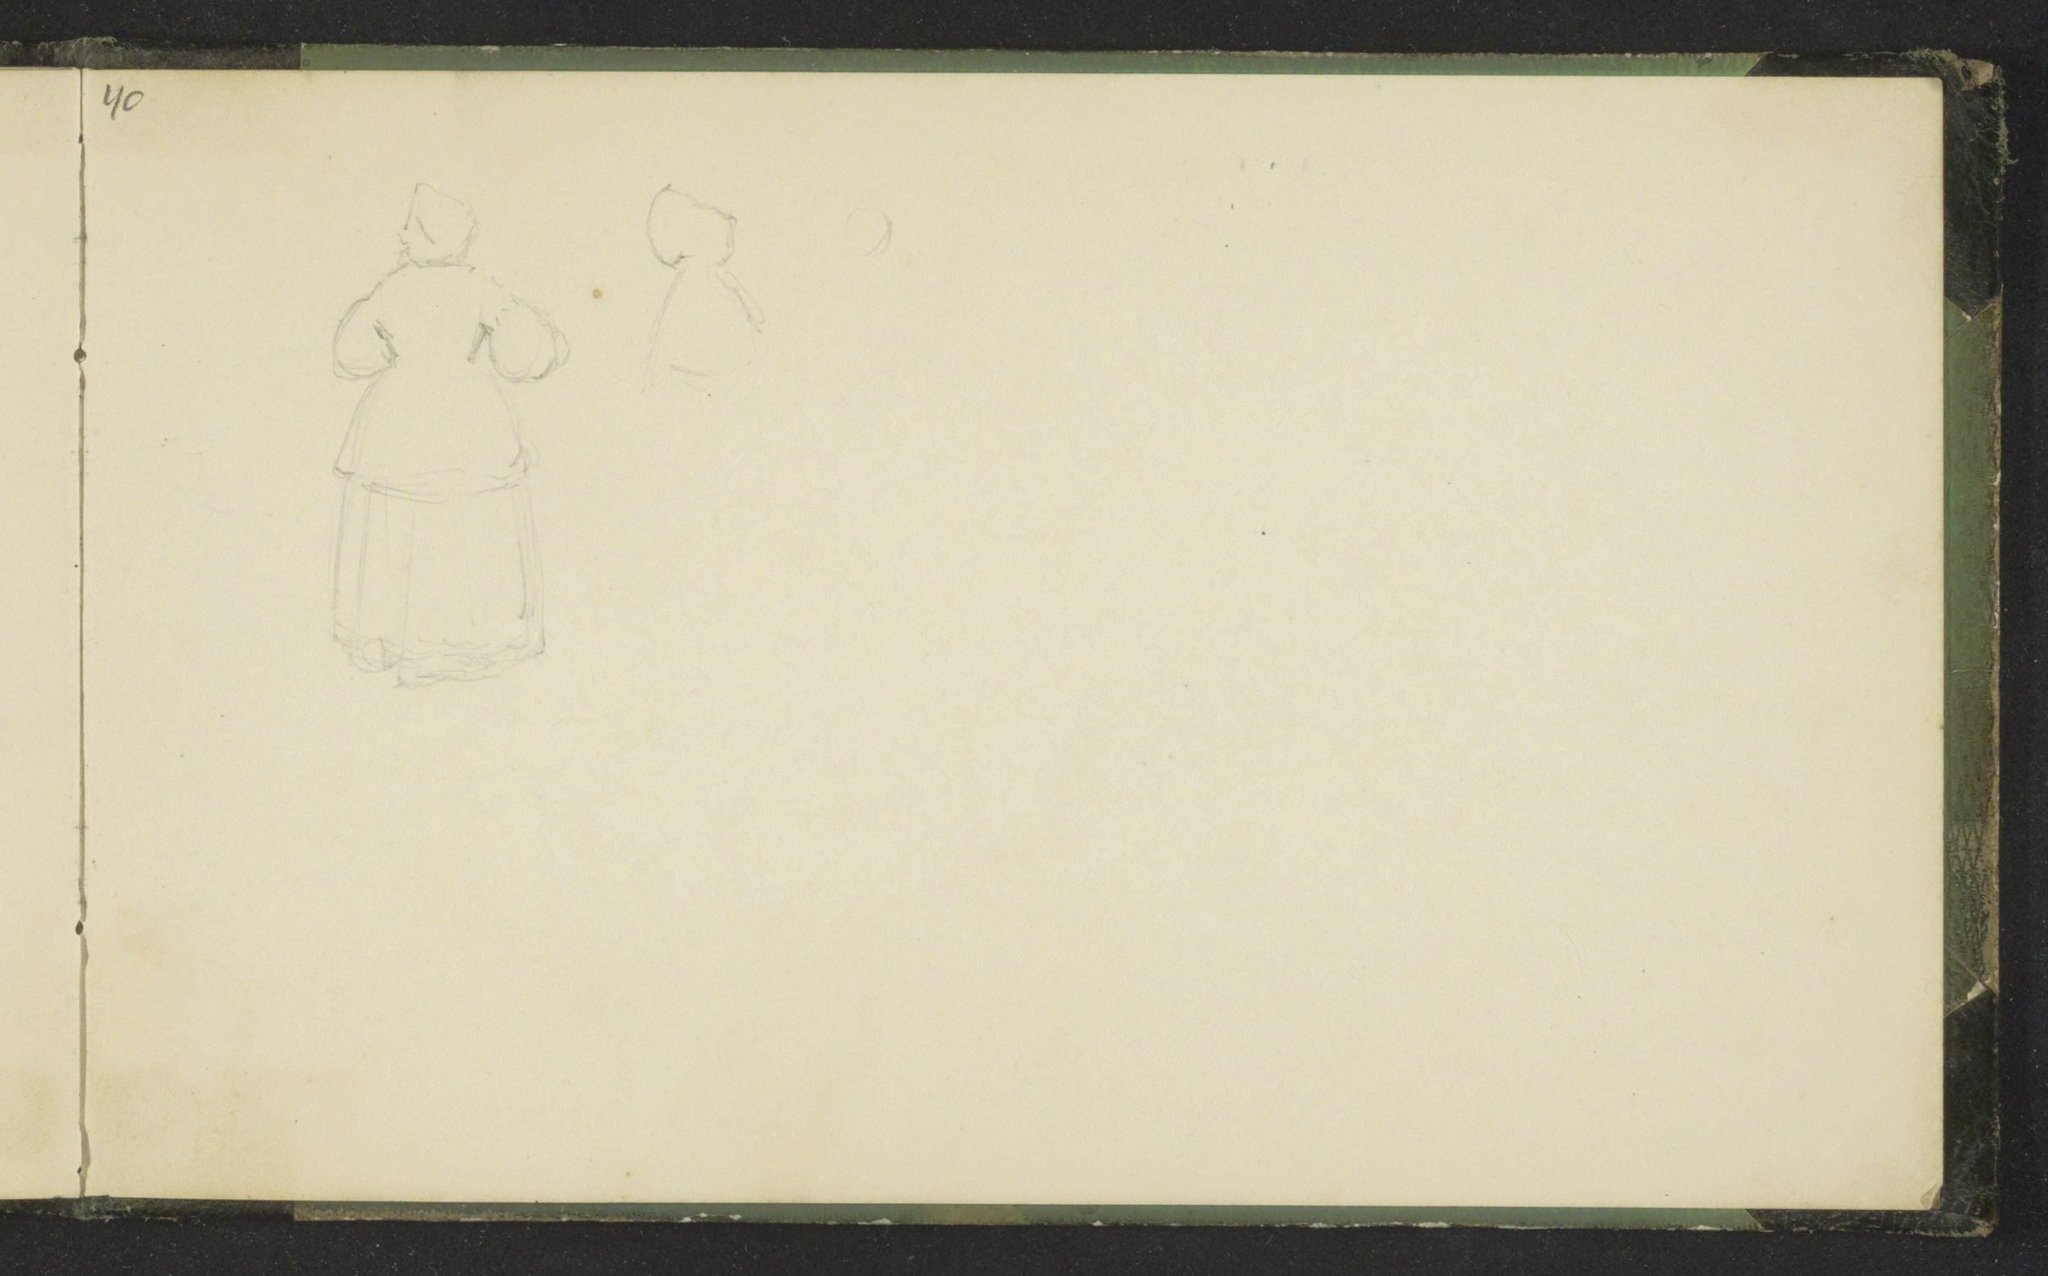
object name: sketchbook leaf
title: Staande vrouw met een muts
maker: hendrik abraham klinkhamer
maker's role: draughtsman, painter, print maker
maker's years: 1810-1872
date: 1808-1843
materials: paper, pencil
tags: head-gear: cap (+ women's clothes), standing figure - aa - female human figure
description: Blad 40 recto uit een schetsboek met 40 bladen.